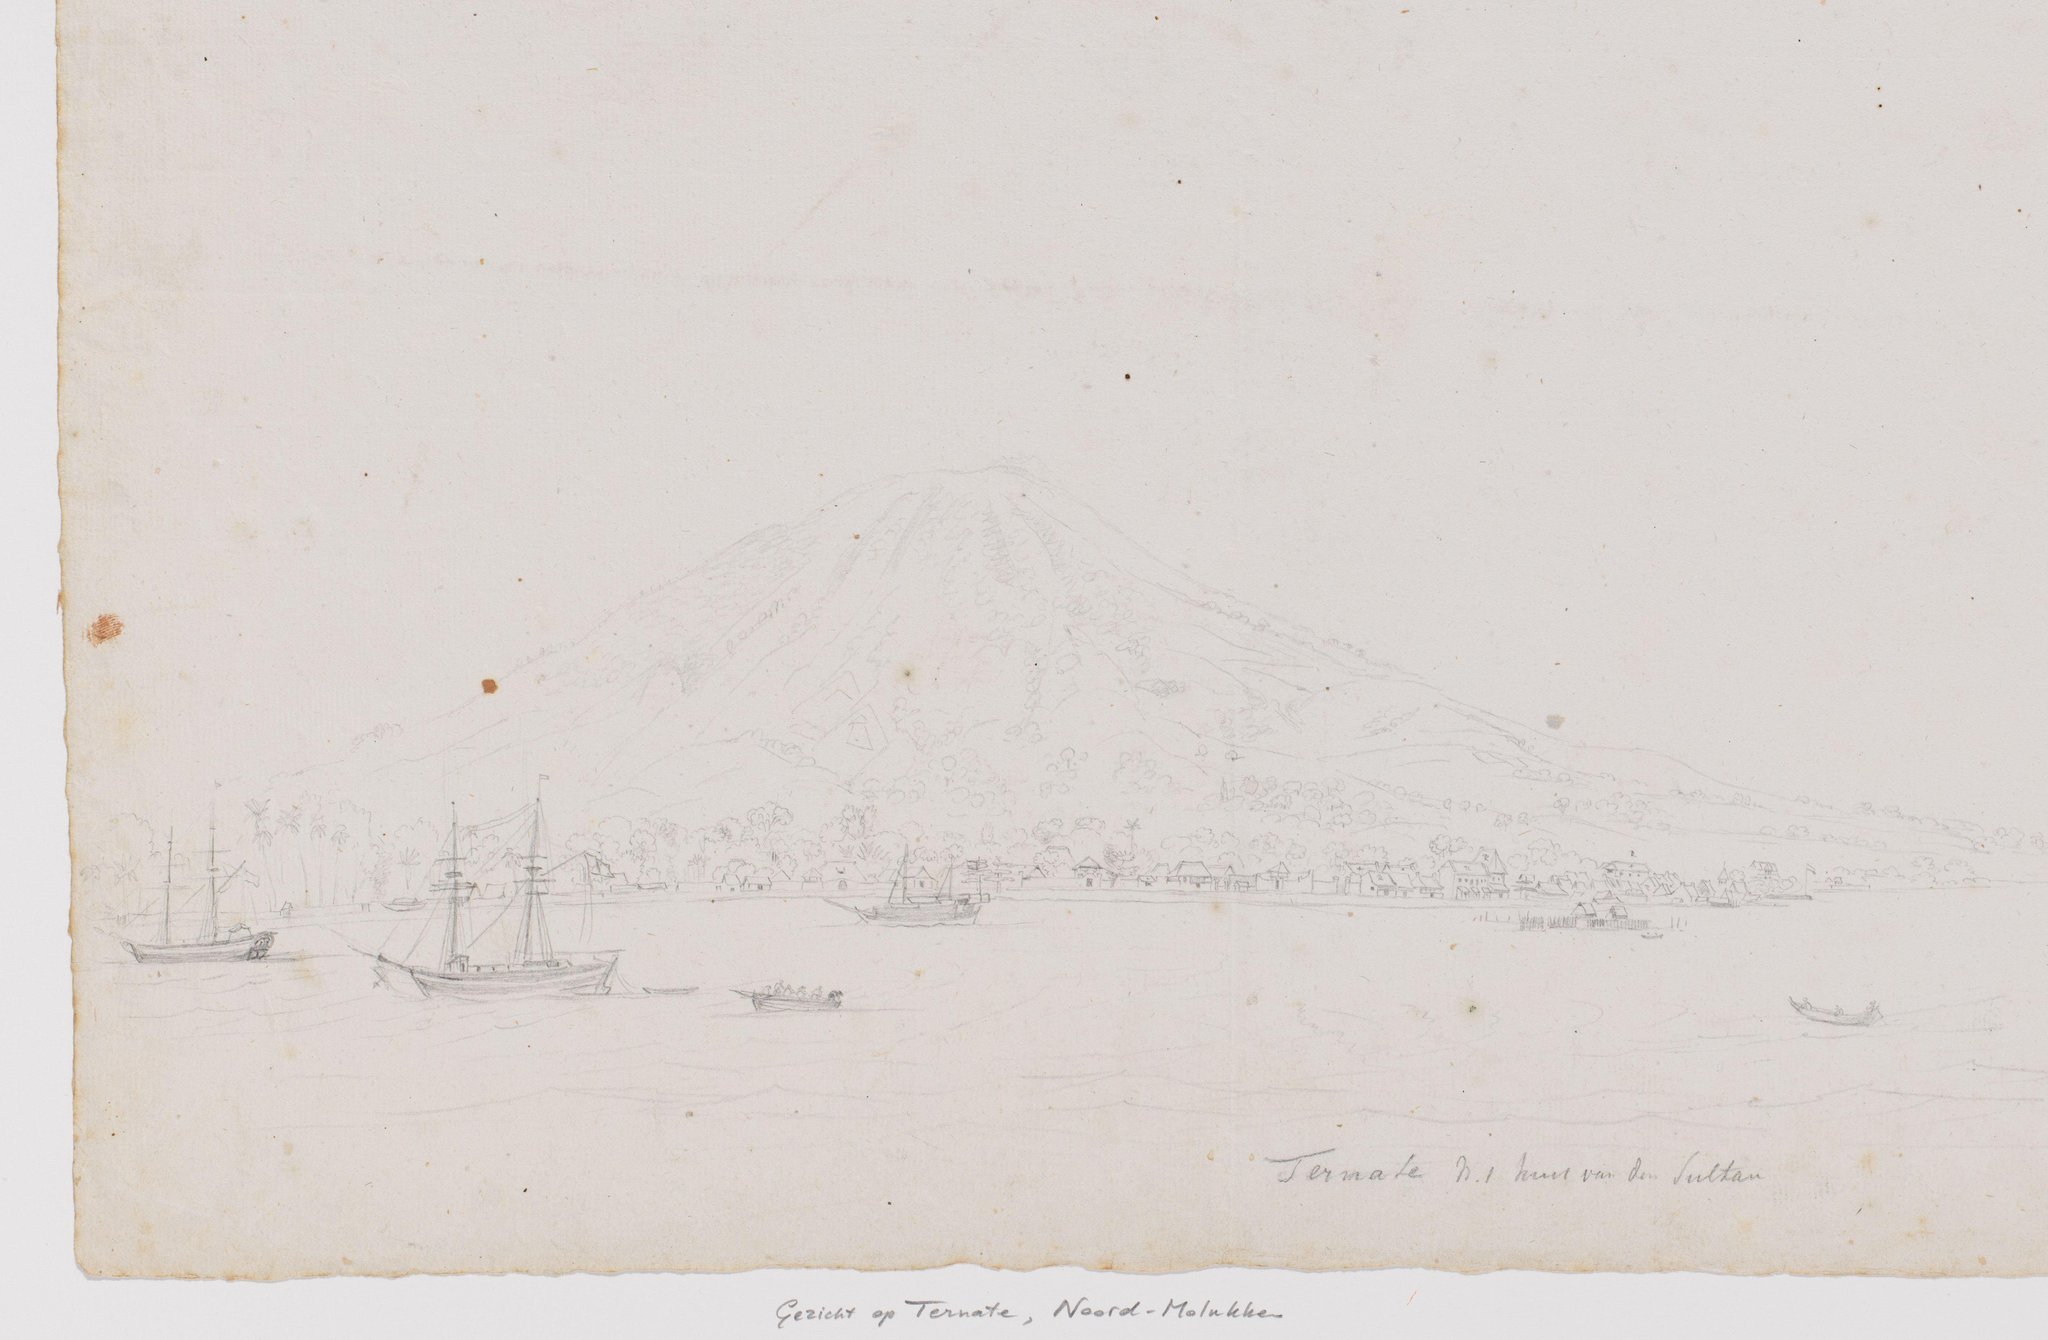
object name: topographical view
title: Gezicht op de kust van Ternate en Gunung Gamalama, vanuit de zee, Noord-Molukken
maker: adrianus johannes bik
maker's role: draughtsman, print maker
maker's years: 1790-1872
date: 1821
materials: paper, pencil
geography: north moluccas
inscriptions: annotation: ‘Ternate nr. 1 huis van de sultan’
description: artikel over deze collectie in Bulletin van het Rijksmuseum 49 [2001], nr. 4, pp.343 e.v.